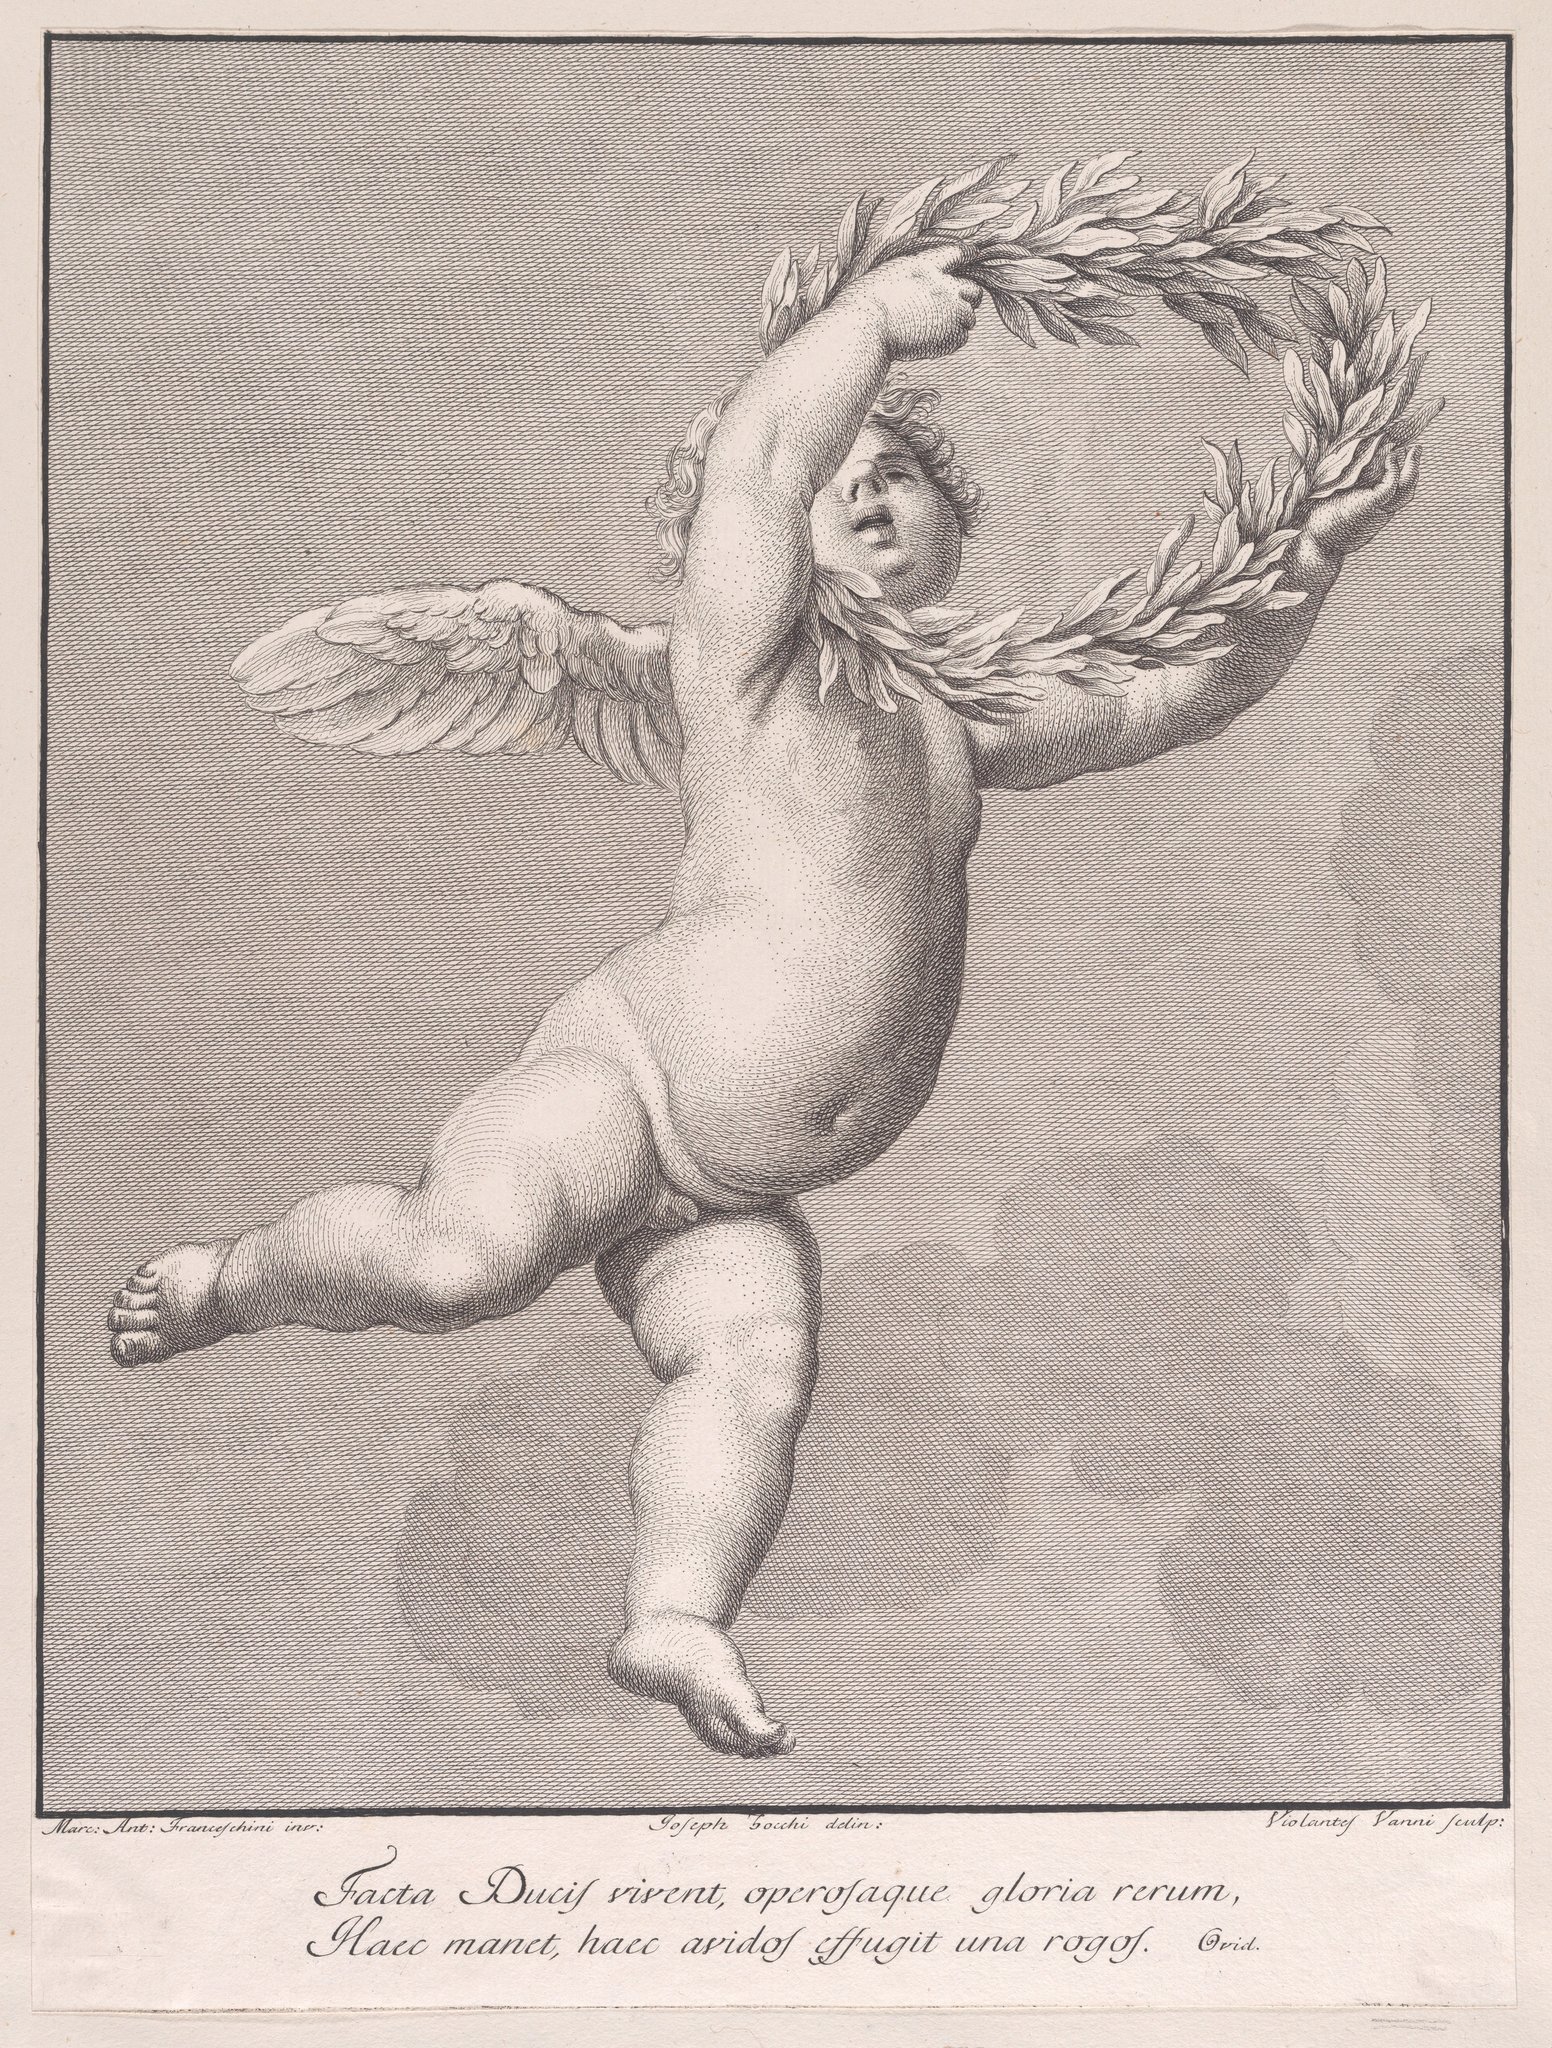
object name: print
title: Amorino with a laurel wreath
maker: violante vanni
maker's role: artist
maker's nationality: italian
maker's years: 1732-1776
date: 1774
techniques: engraving, etching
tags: putti